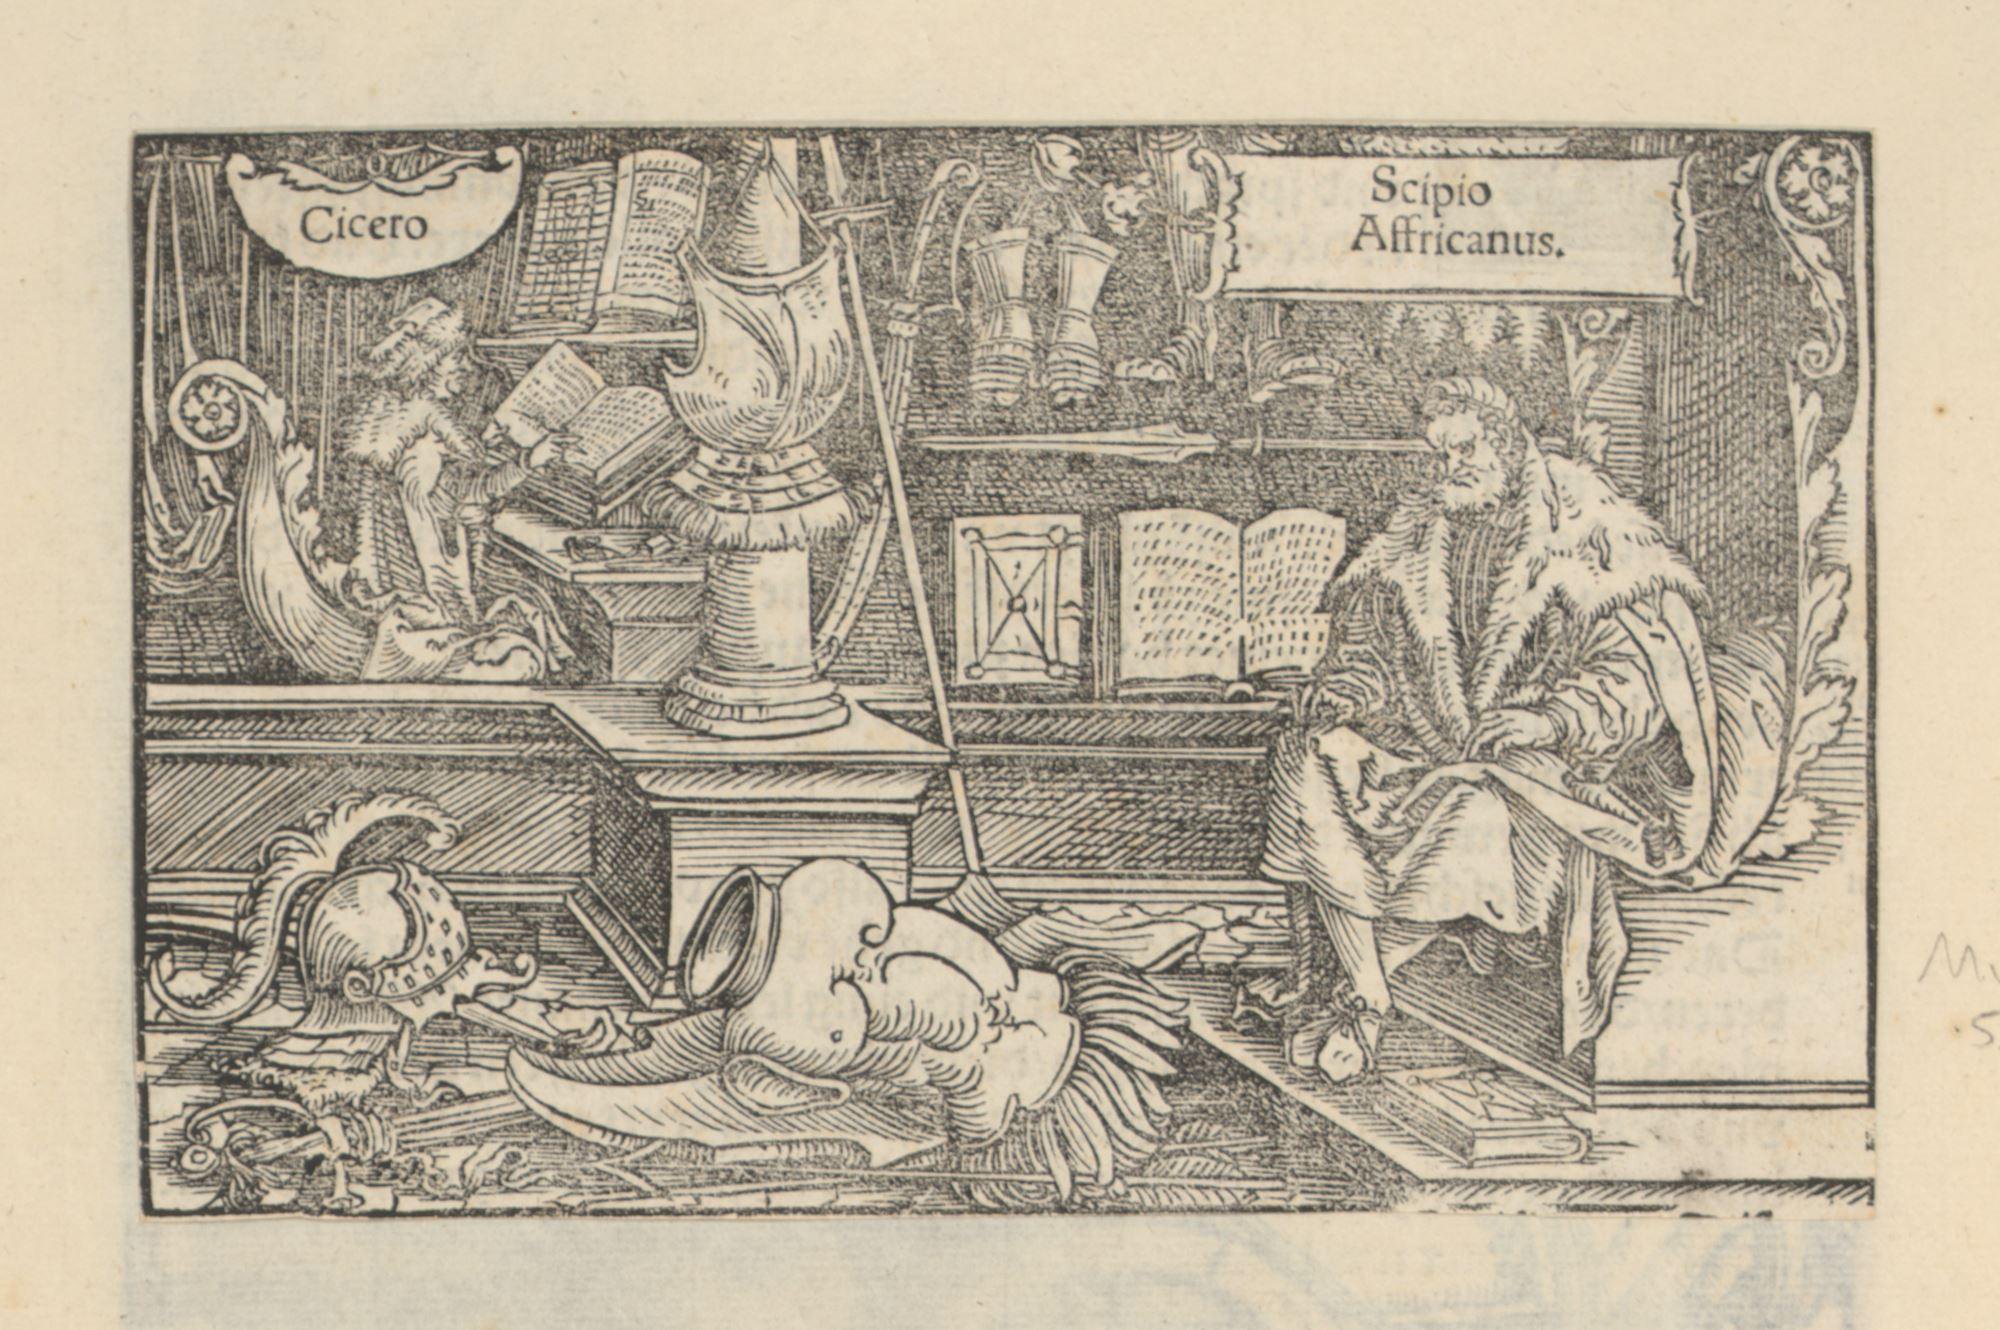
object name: book illustration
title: Scipio Africanus Maior kijkt naar een wapenuitrusting en Cicero schrijft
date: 1514-1531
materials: paper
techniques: letterpress printing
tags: (story of) cicero, (story of) p. cornelius scipio africanus minor (p. cornelius scipio aemilianus), (story of) p. cornelius scipio africanus major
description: Deze prent is gebruikt in: Cicero, Marcus Tulius. Officia M.T.C. Ein Buch so Marcus Tullius Cicero der Römer zu seynem (...). [Vertaald uit het Latijn door] Johann von Schwarzenberg. Augsburg: Heinrich Steiner, 1531.